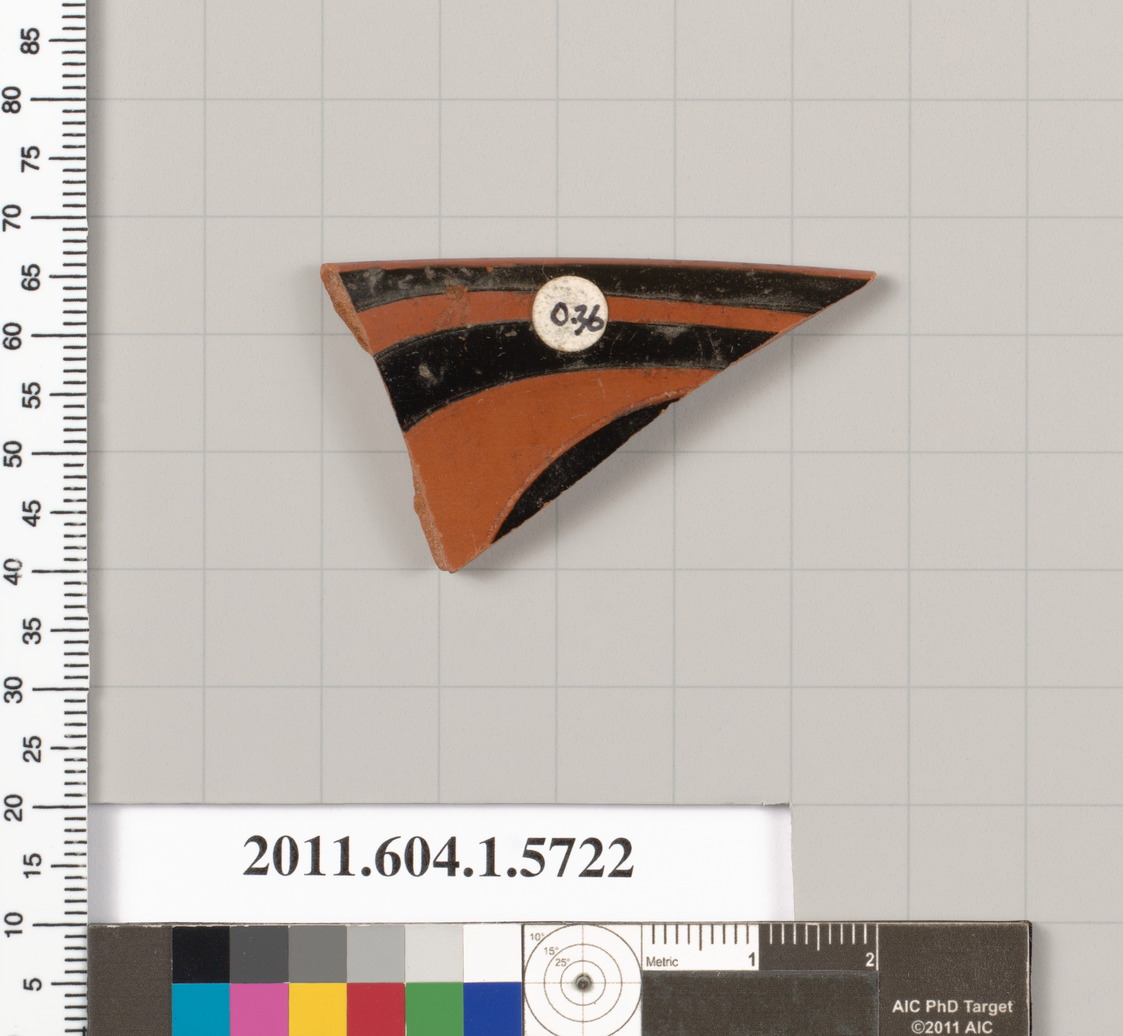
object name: kylix fragment, eye cup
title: Terracotta rim fragment of a kylix: eye-cup (drinking cup)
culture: greek, attic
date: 525-515 BCE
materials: terracotta